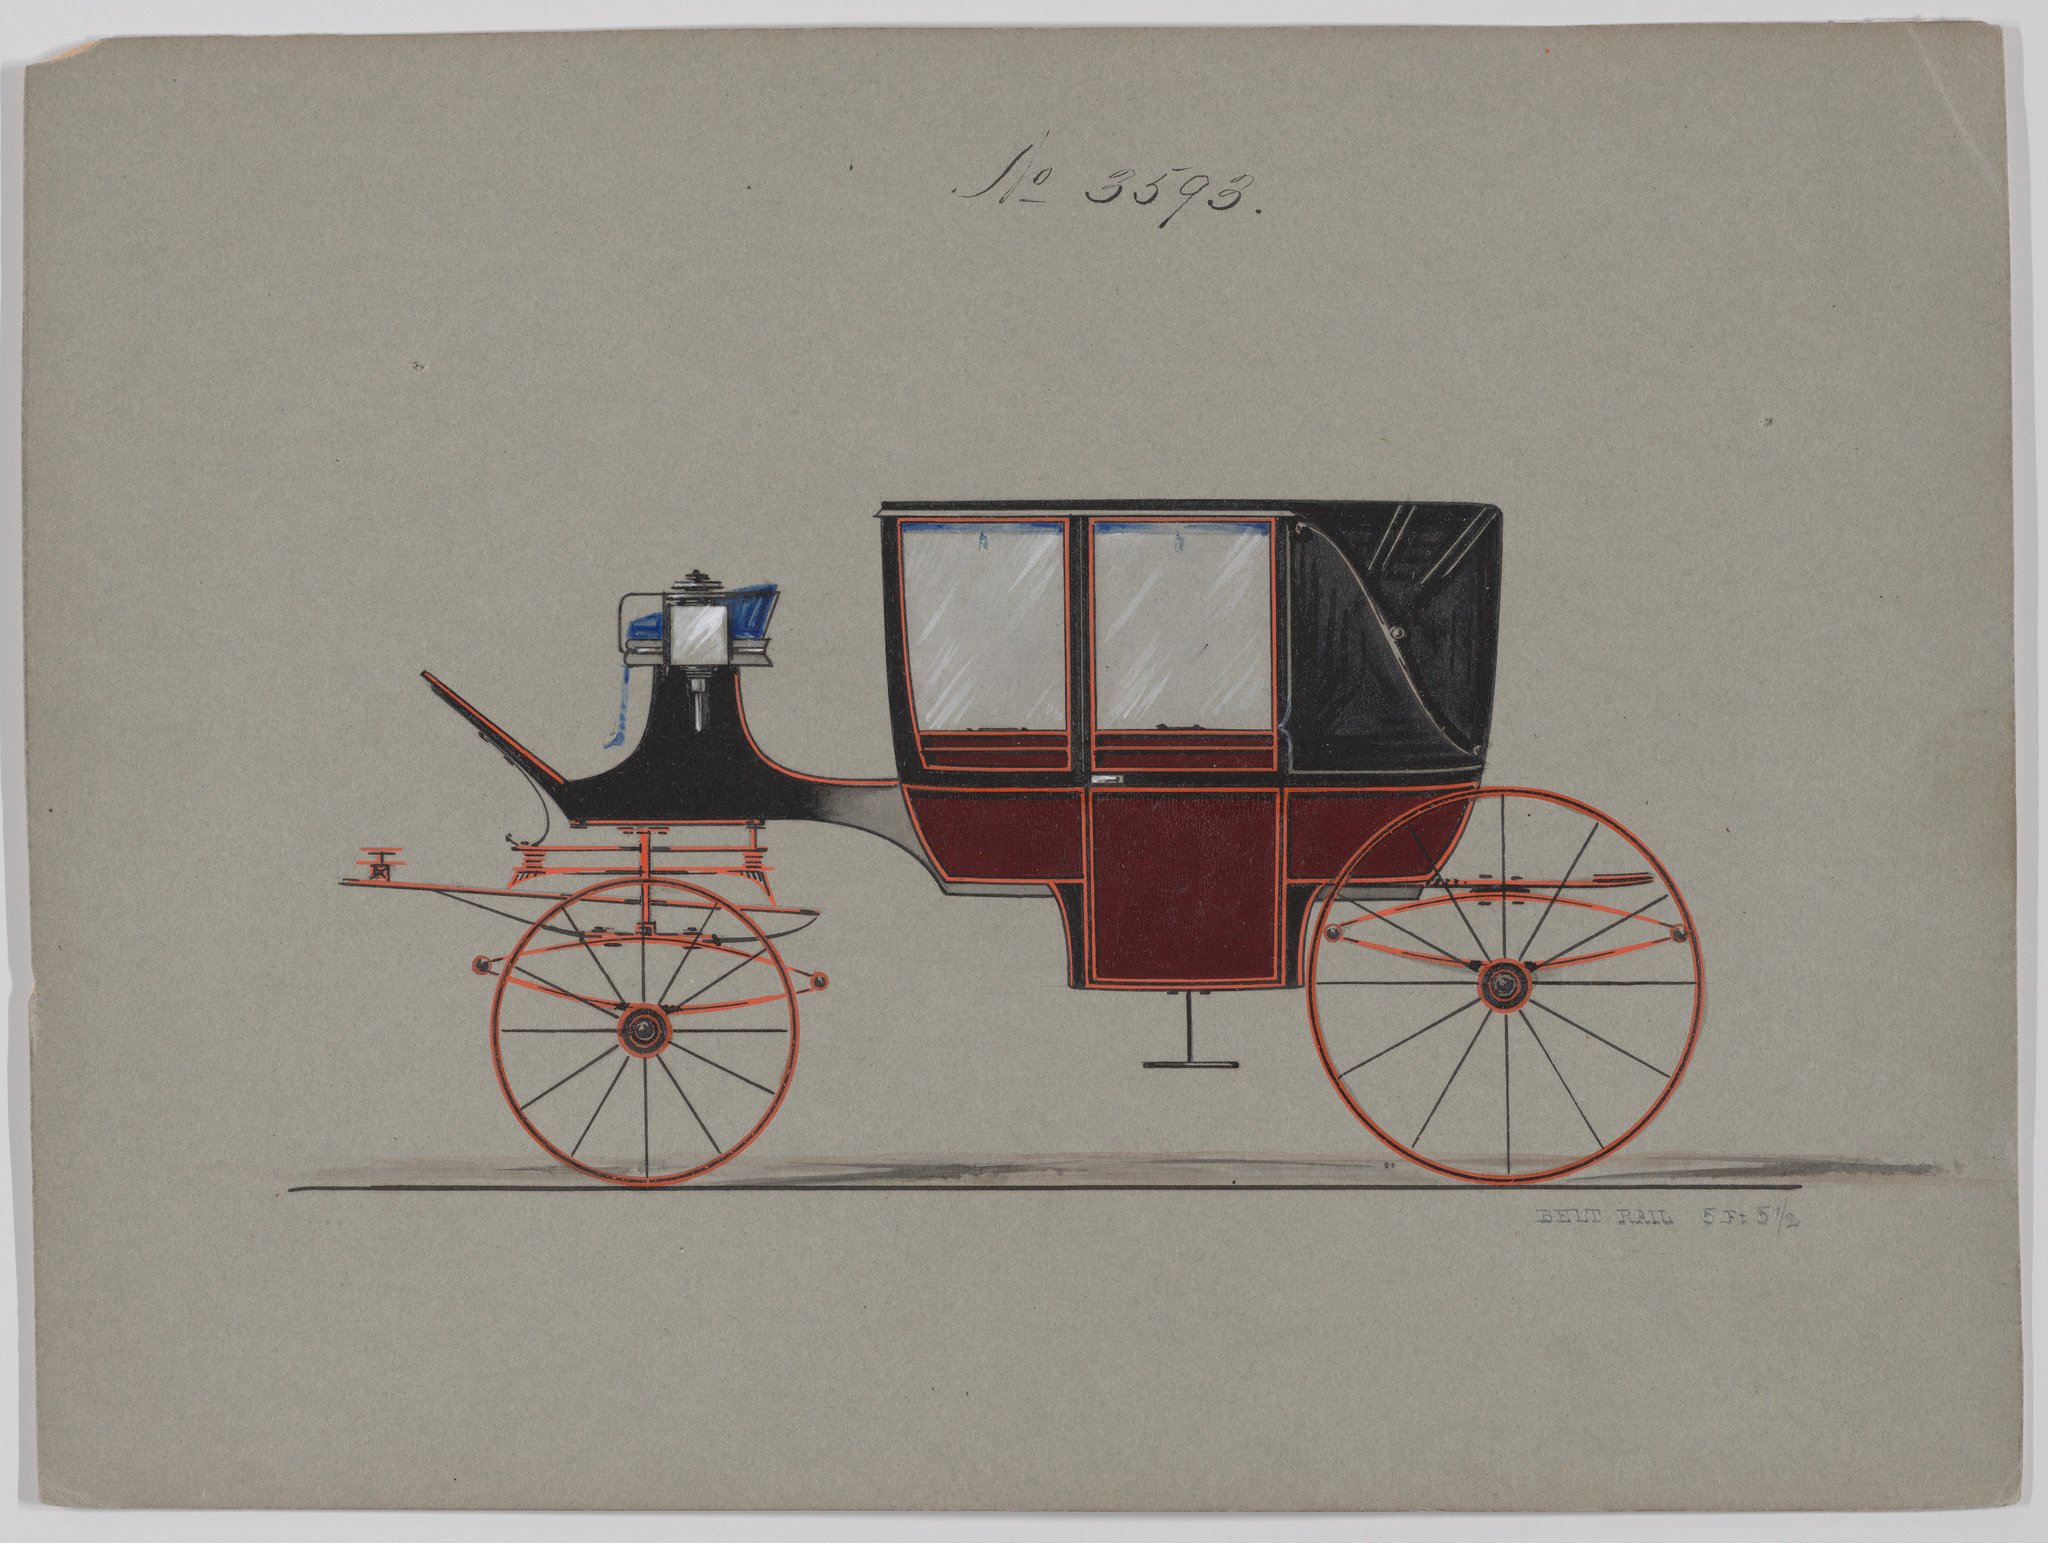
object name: drawing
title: Design for Landau, No. 3593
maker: brewster & co.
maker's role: manufacturer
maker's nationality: american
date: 1880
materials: gouache, gum arabic, ink, watercolor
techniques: pen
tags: carriages